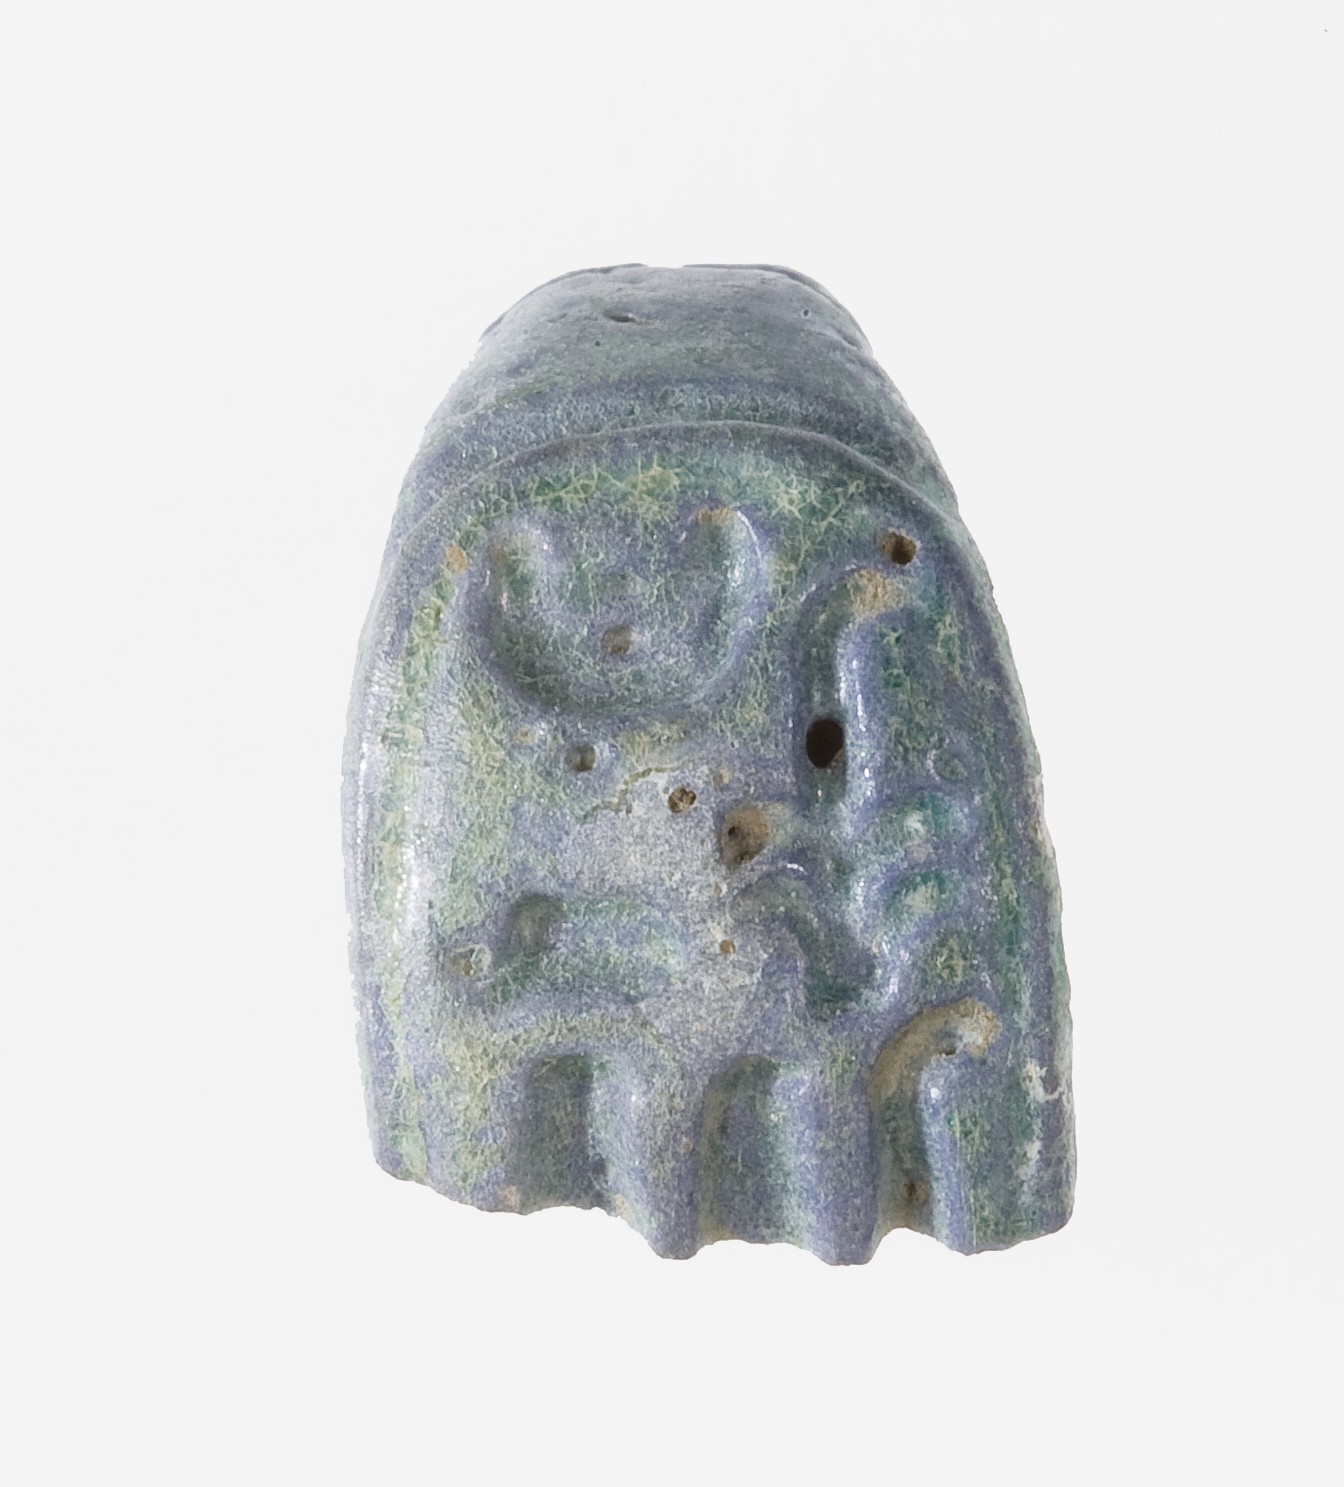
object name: ring fragment, tiy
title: Ring Fragment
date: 1390-1352 BCE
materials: faience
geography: egypt